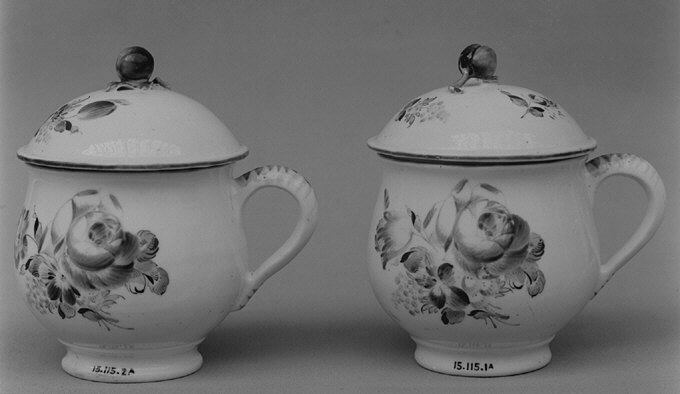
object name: cream pot with cover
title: Cream pots with covers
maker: mennecy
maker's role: factory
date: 1760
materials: soft paste porcelain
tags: flowers